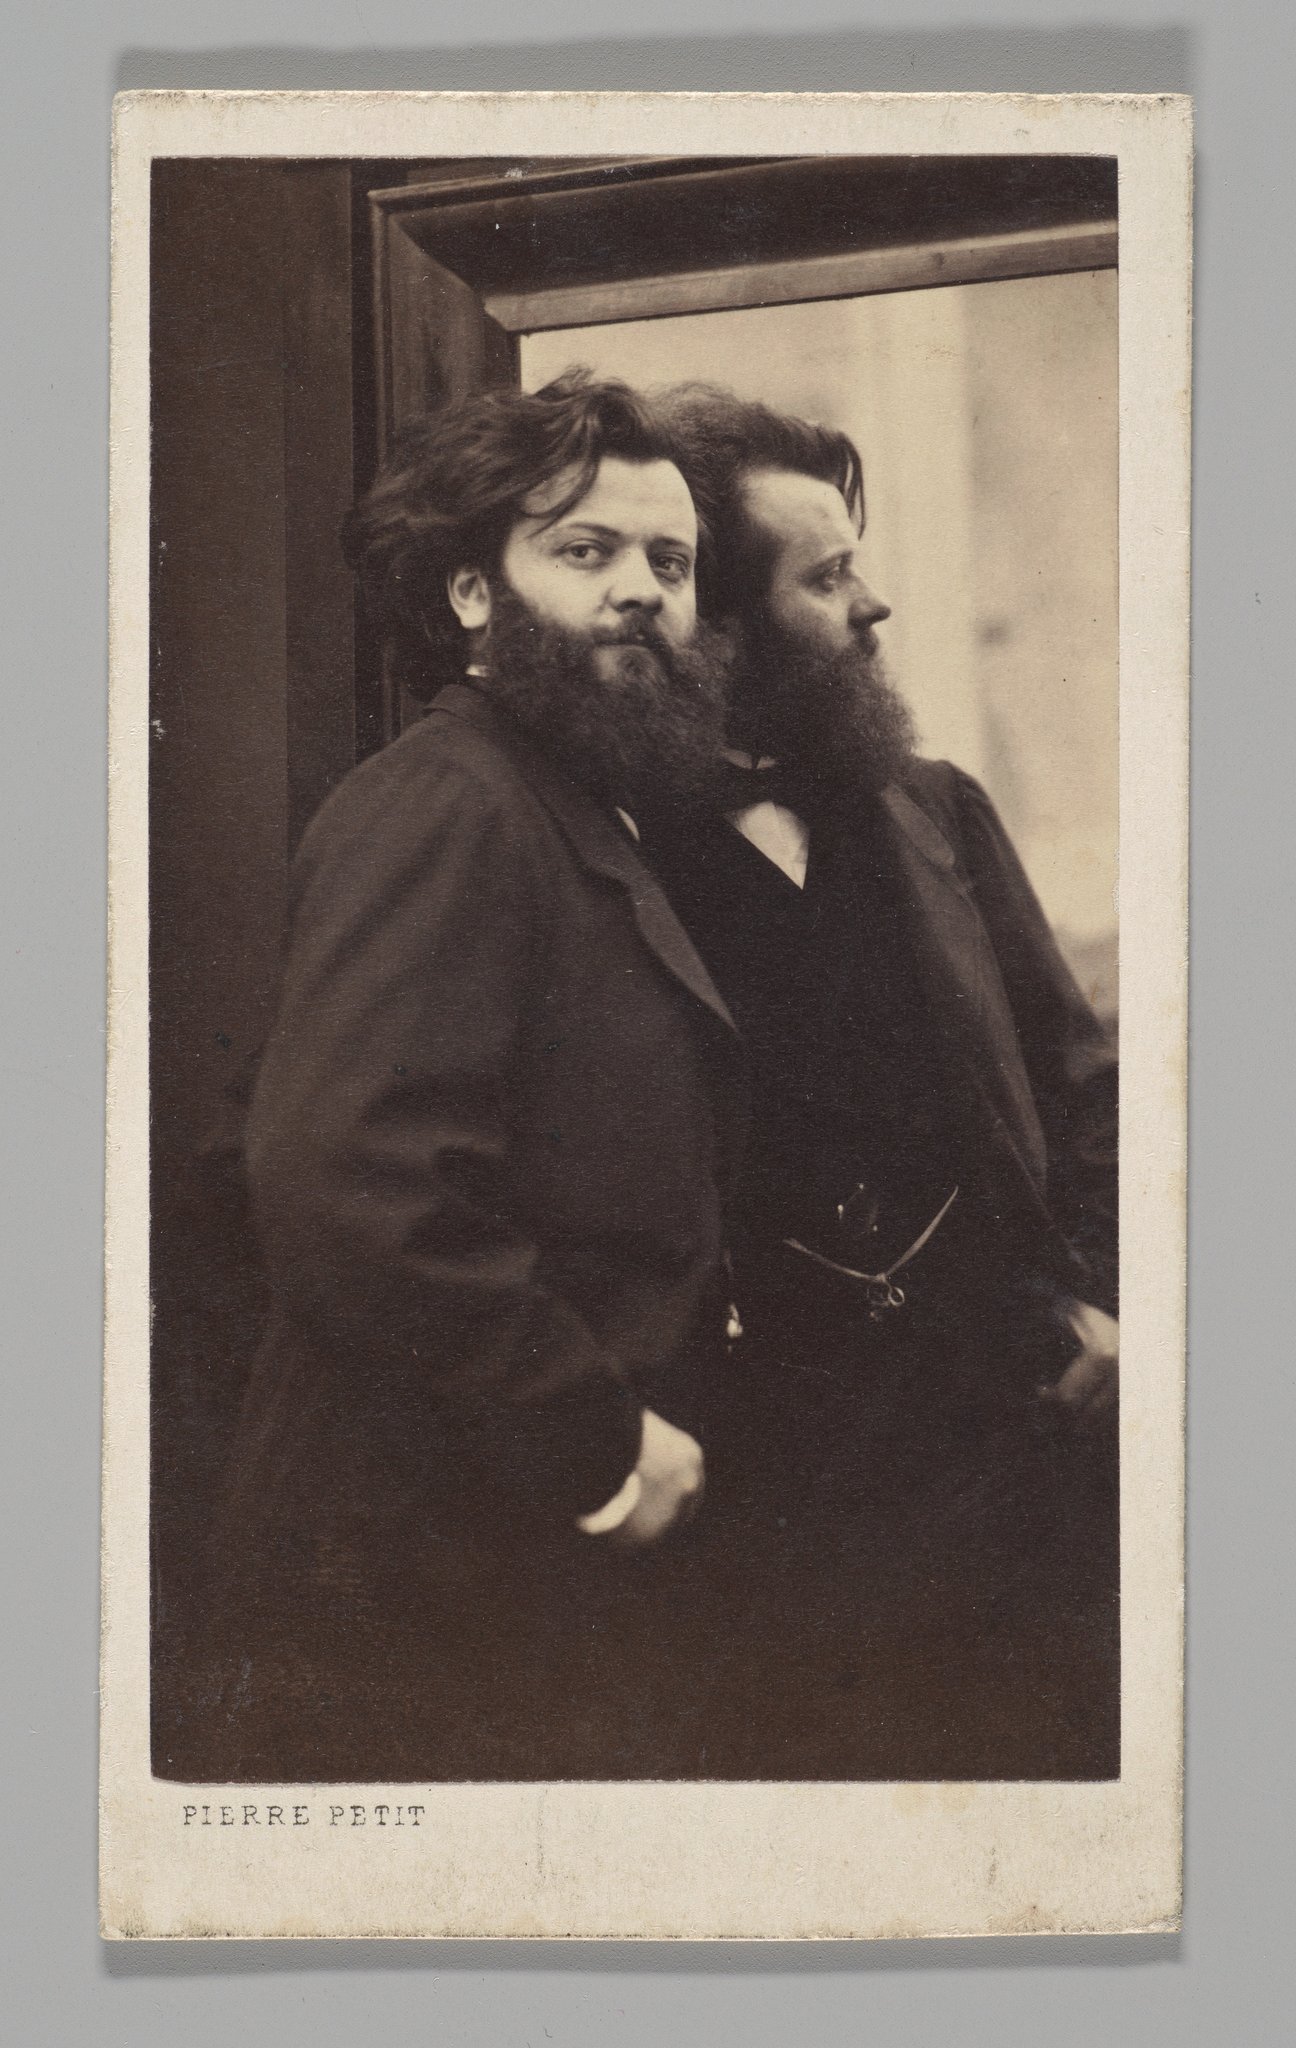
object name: carte de visite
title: [Studio Portrait: Self-Portrait Standing by a Mirror]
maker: pierre petit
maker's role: fotograaf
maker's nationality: french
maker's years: 1832-1909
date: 1860-1869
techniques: albumen silver print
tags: men,portraits